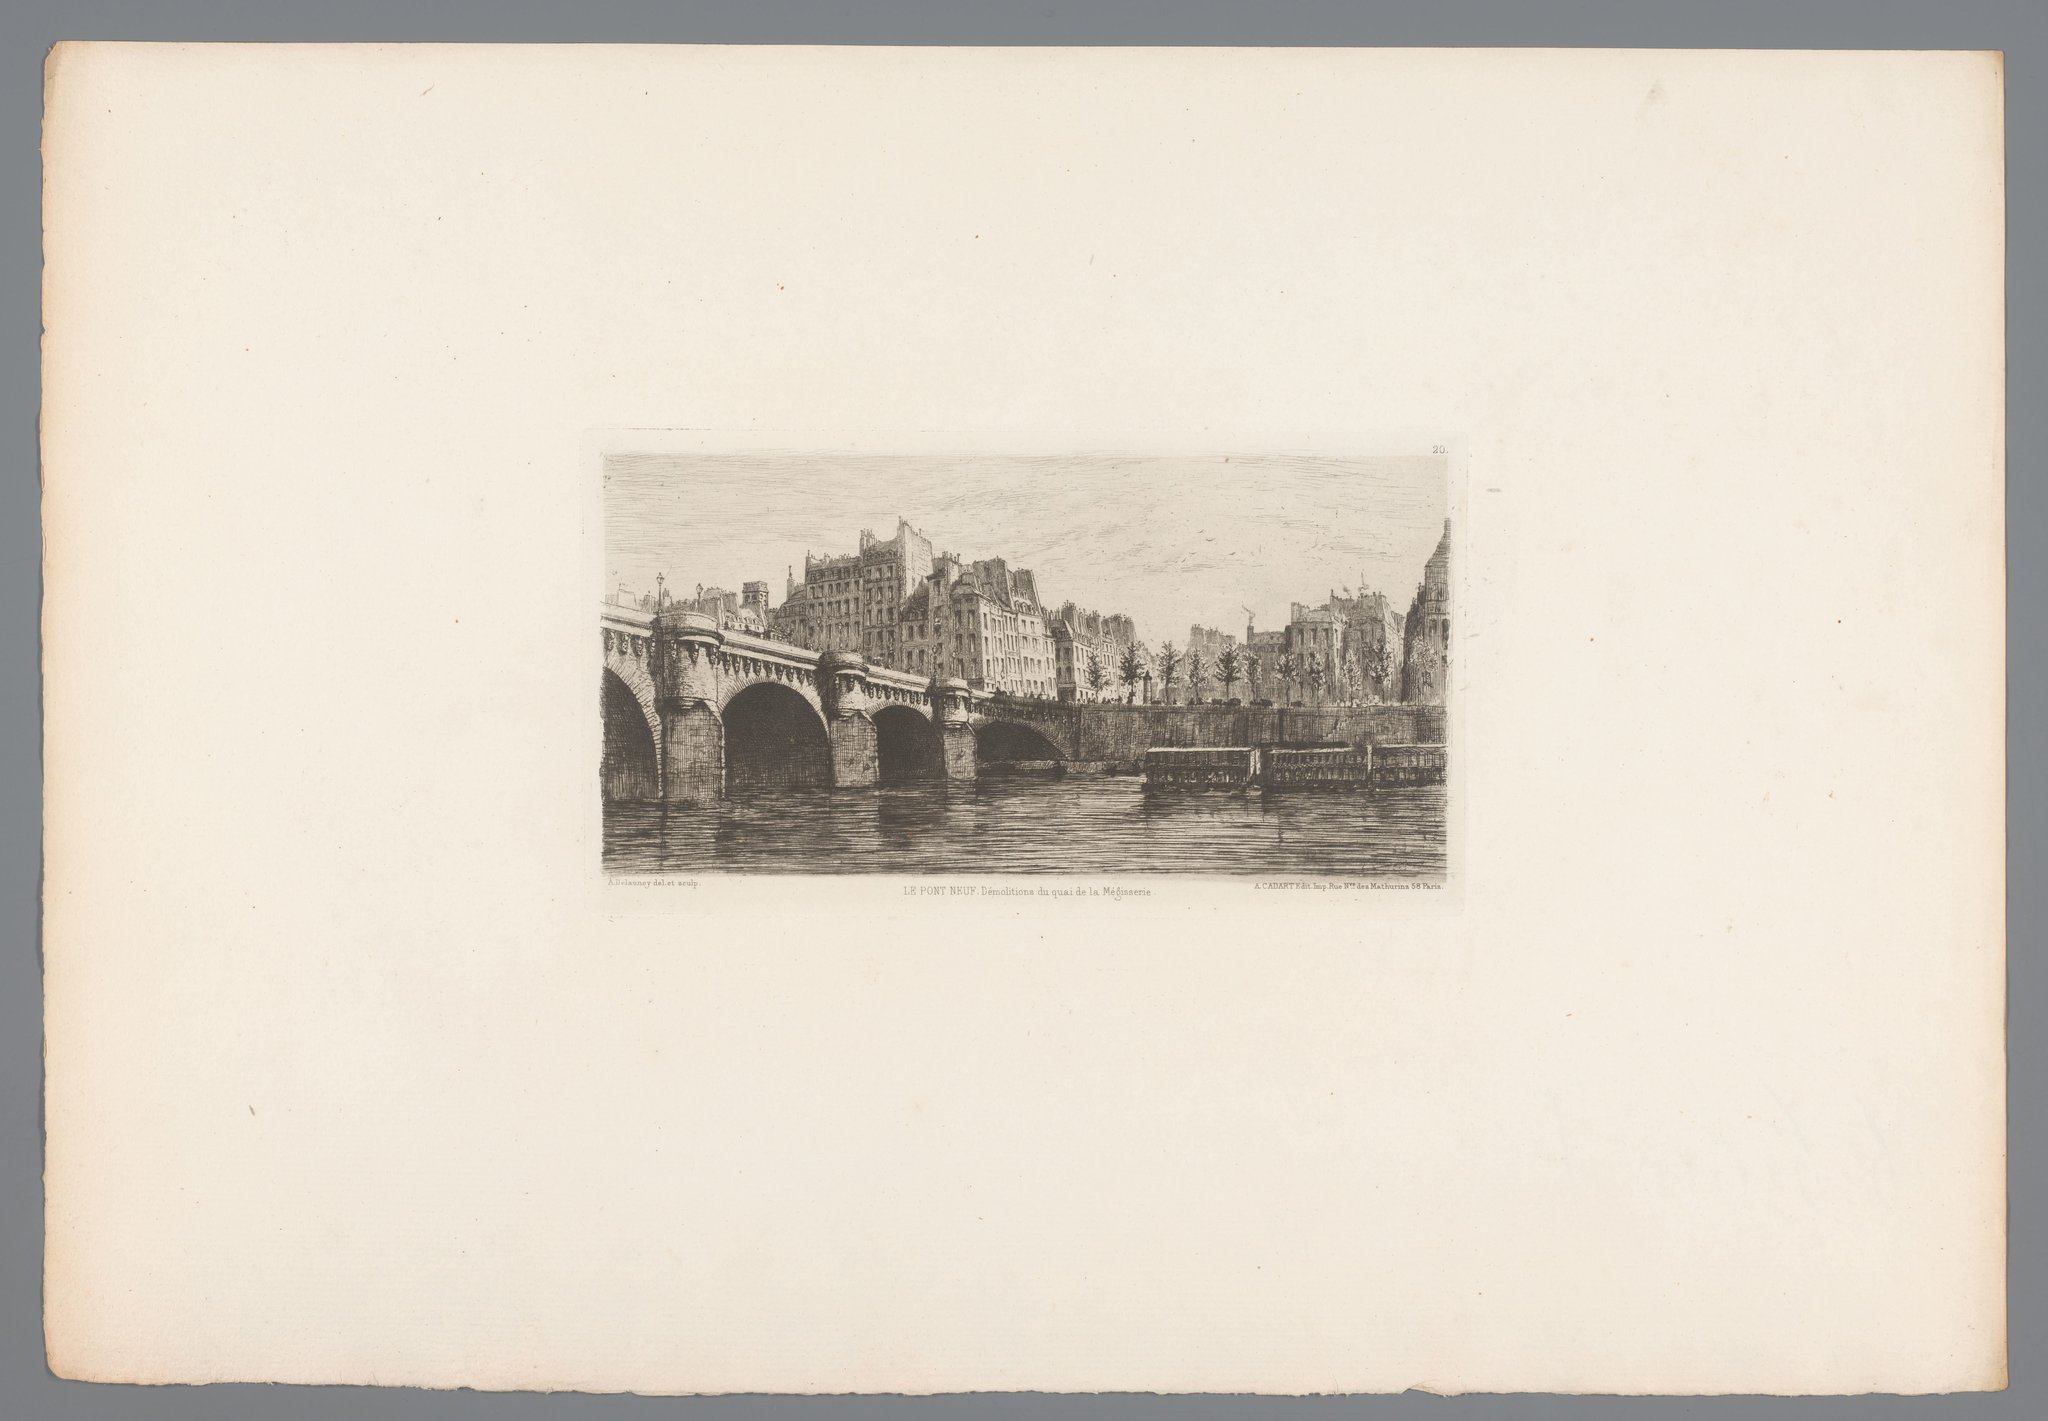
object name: print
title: Gezicht op de Pont Neuf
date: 1874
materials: paper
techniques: drypoint, etching, intaglio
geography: paris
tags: bridge in city across river, canal, etc.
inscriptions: collector's mark: Lugt 2228, collector's mark: Lugt 2760, collector's mark: ‘AFE v S’